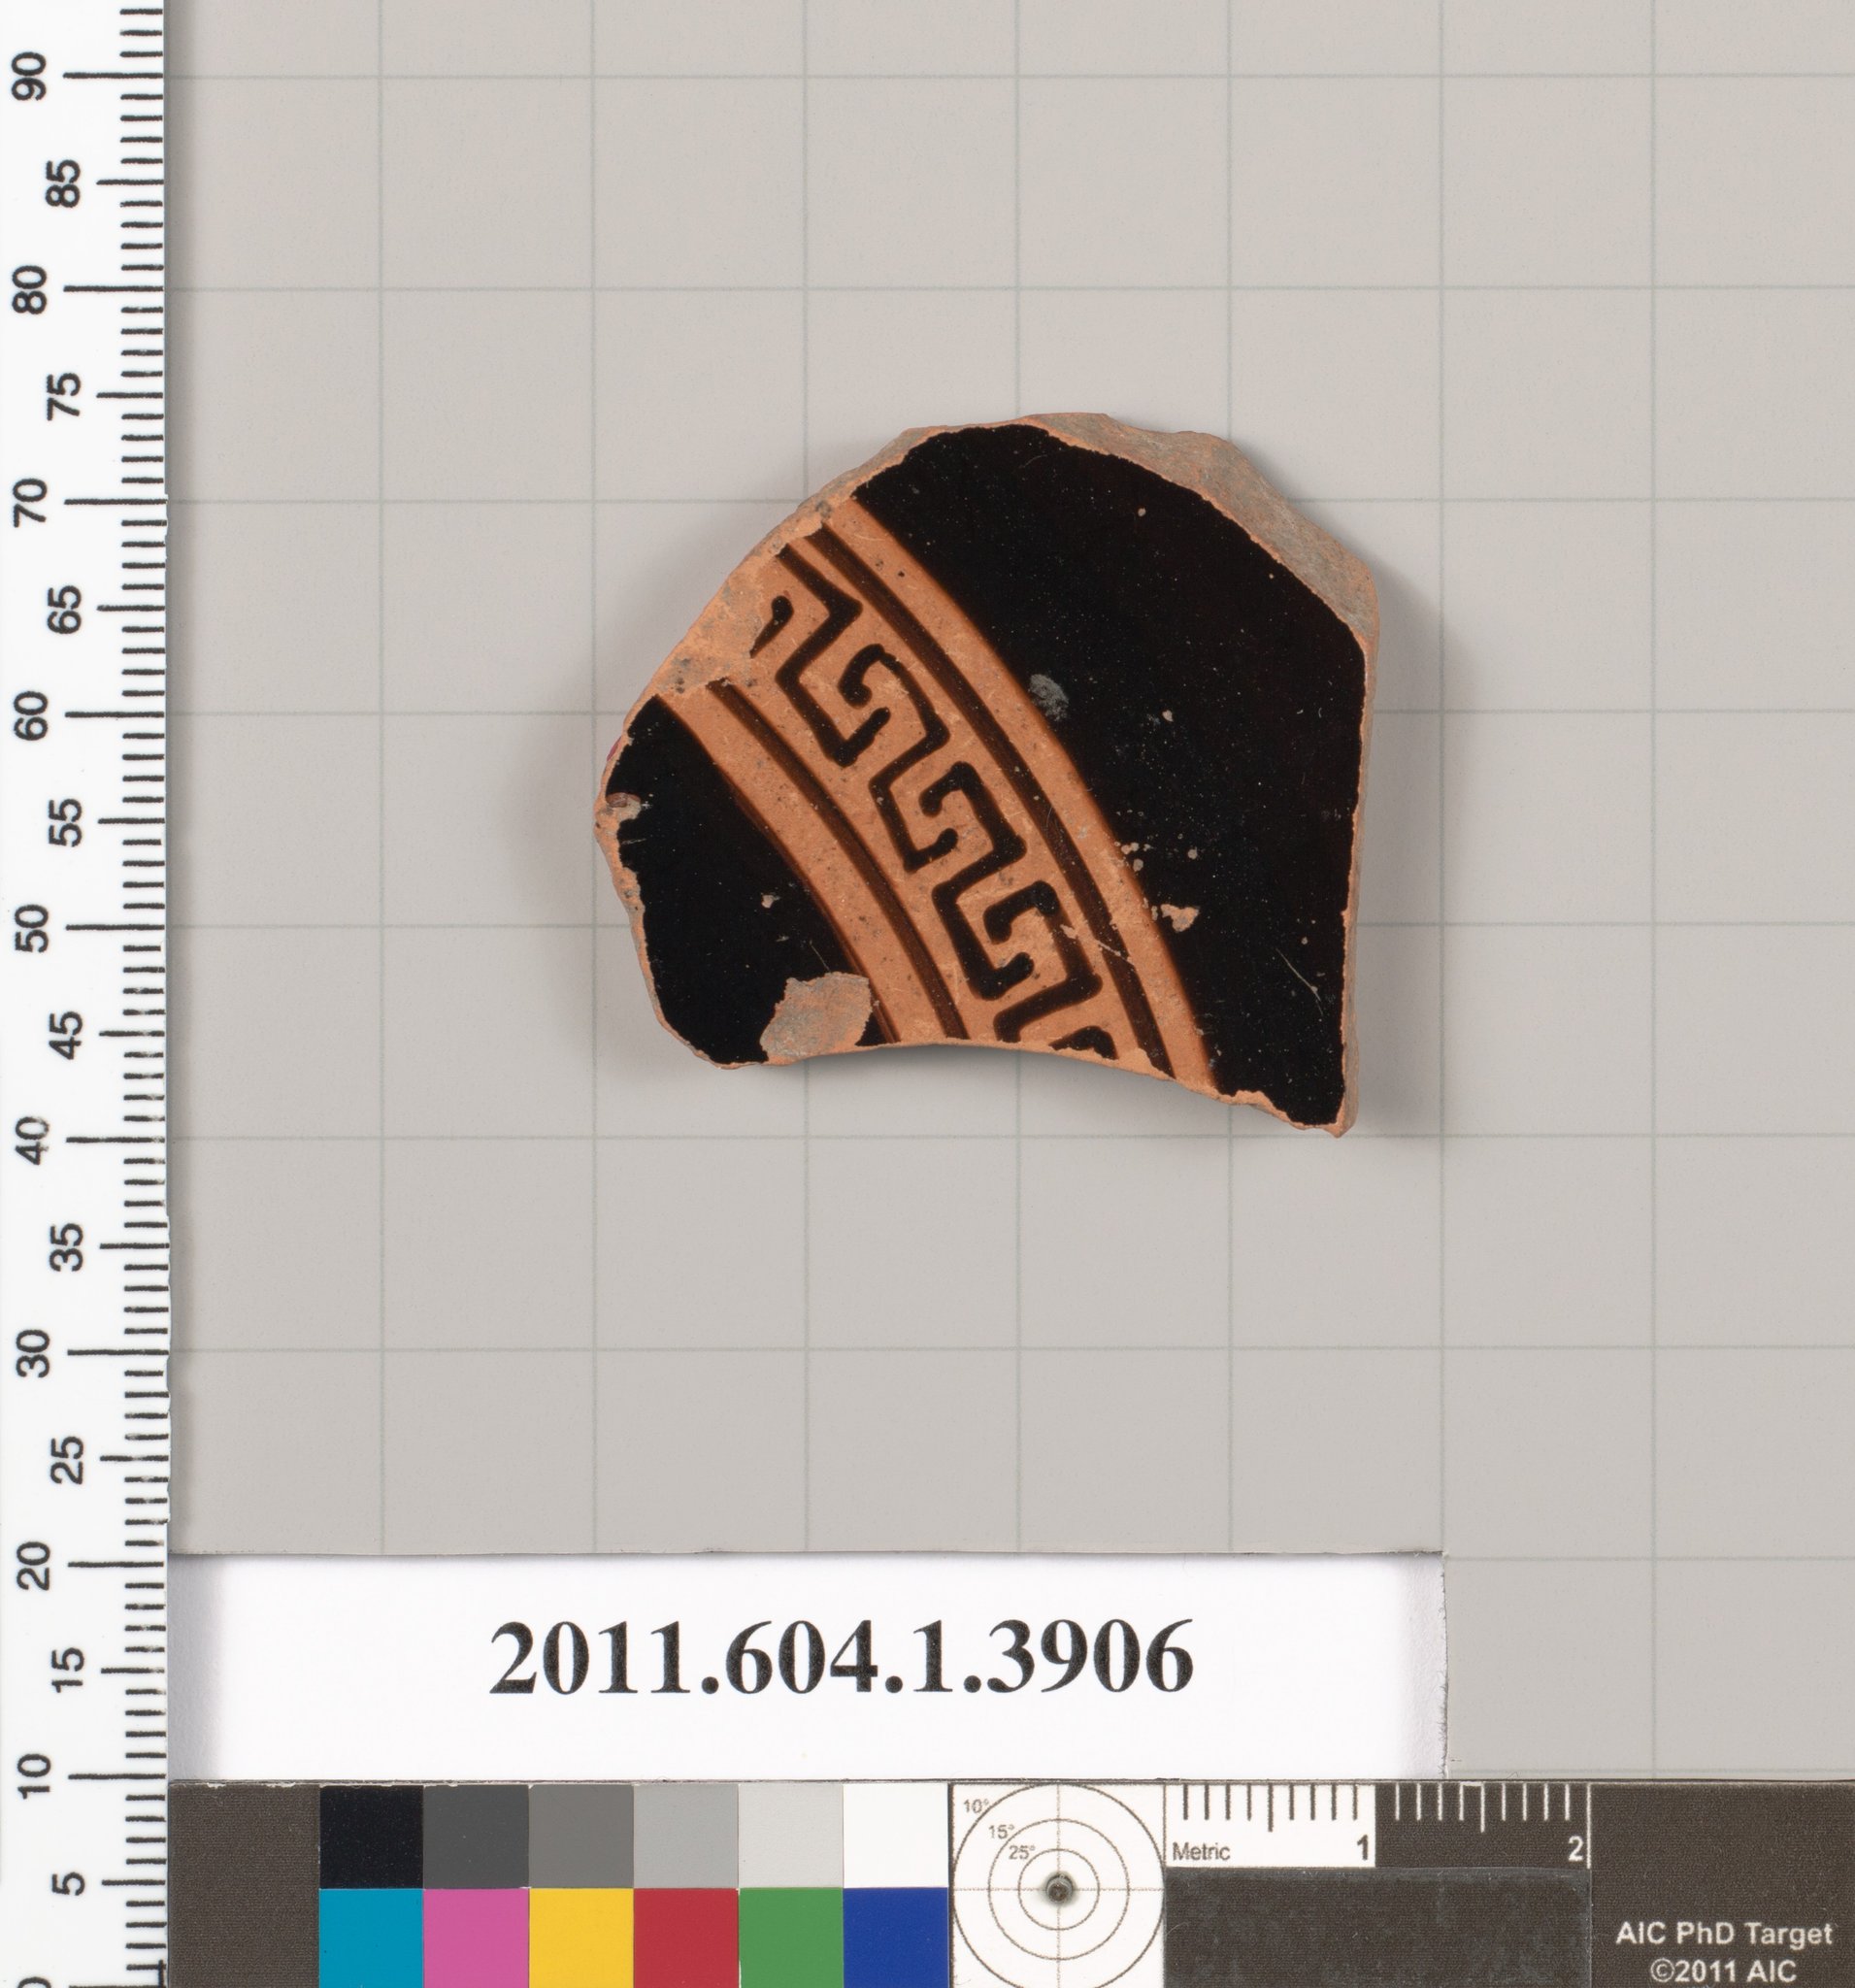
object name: kylix fragment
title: Terracotta fragment of a kylix (drinking cup)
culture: greek, attic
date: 500-476 BCE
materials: terracotta